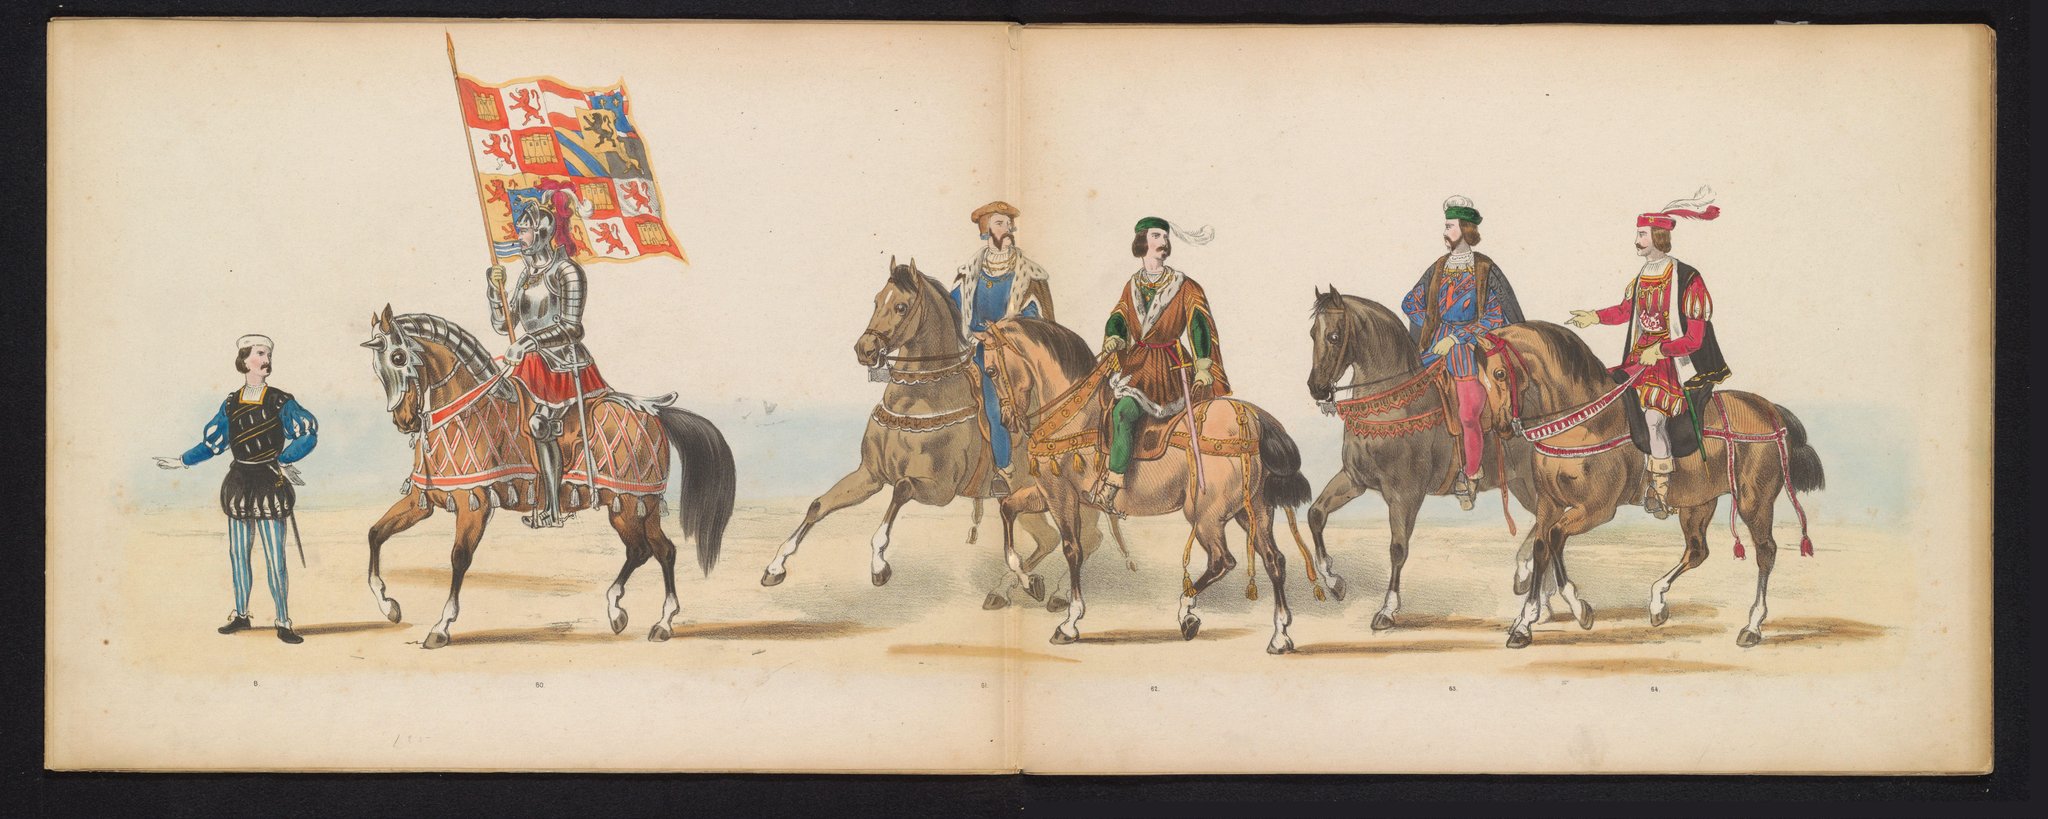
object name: print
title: Gecostumeerde optogt gehouden door de leden van het Leidsche studenten-corps den 12den Junij 1855, ter viering van den 280sten verjaardag der Leidsche Hoogeschool, voorstellende de intrede van Karel V binnen Dordrecht op den 3den Junij 1515, bij gelegenheid zijner huldiging tot Graaf van Holland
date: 1855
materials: paper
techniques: hand coloring, lithograph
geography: netherlands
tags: charles v (holy roman emperor and king of spain), students' pageant, costumes used in pageants, leiden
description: Historische gekostumeerde optocht van de studenten van de Hogeschool van Leiden op 12 juni 1855 ter gelegenheid van het 280-jarig bestaan van de Hogeschool. De optocht verbeeldt de intocht van keizer Karel V te Dordrecht op 3 juni 1515 bij zijn huldiging tot graaf van Holland. Zevende plaat met de groepen genummerd 60-64. Onderdeel van een serie van veertien aanelkaar geplakte bladen.